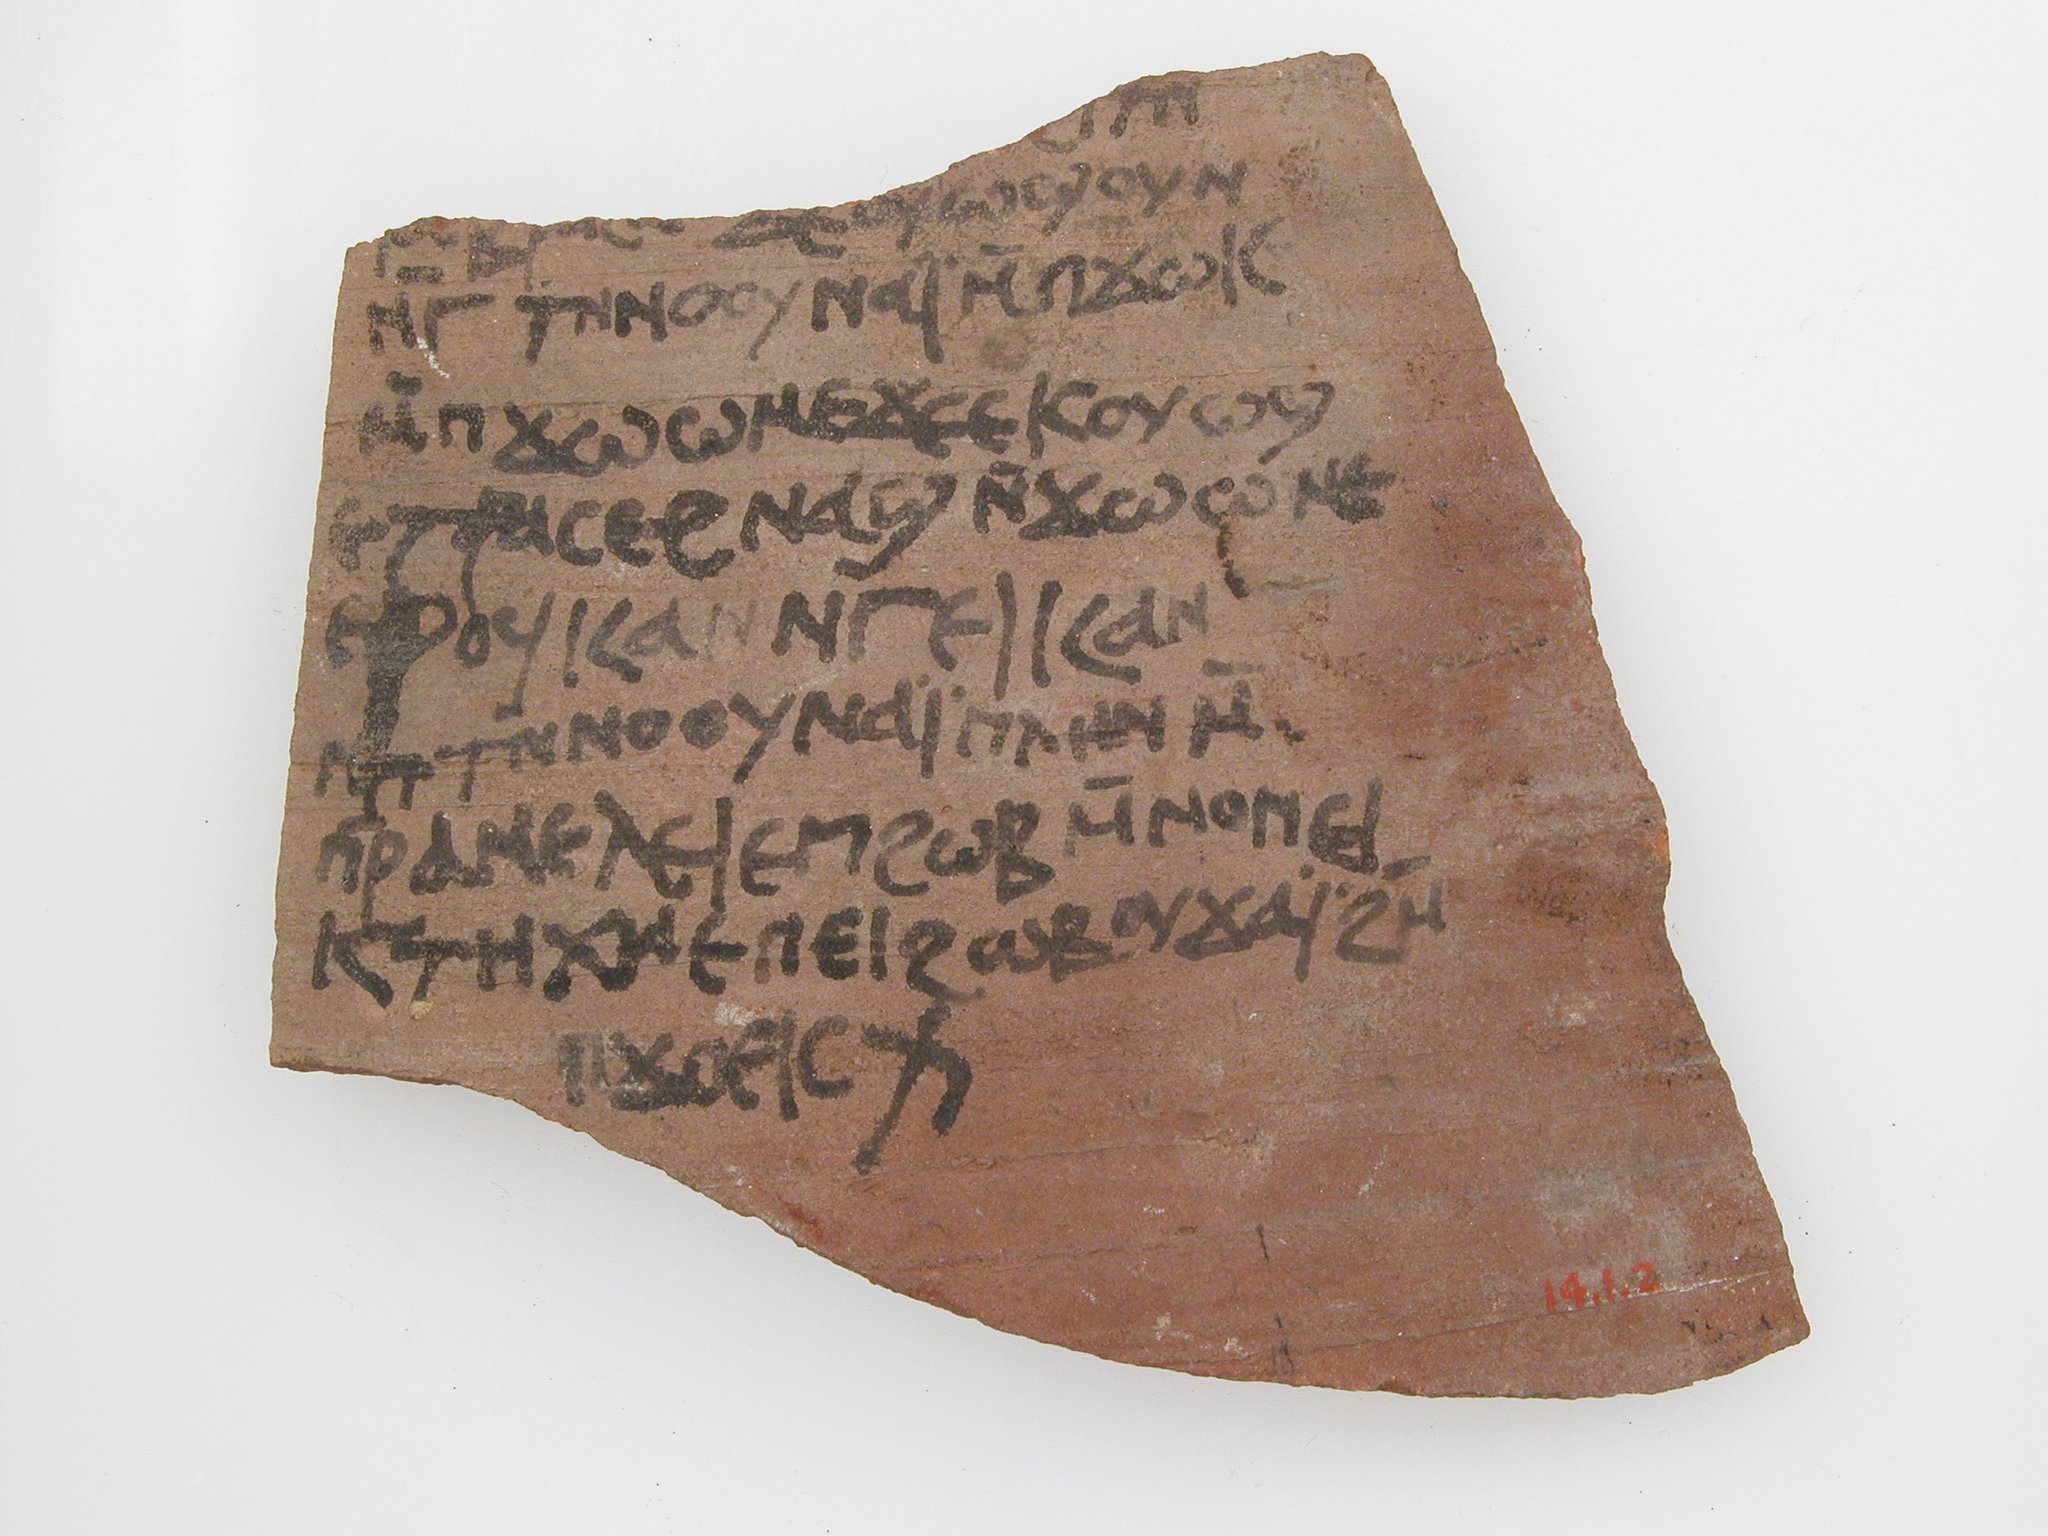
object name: ostrakon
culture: coptic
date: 600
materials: ink, pottery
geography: egypt